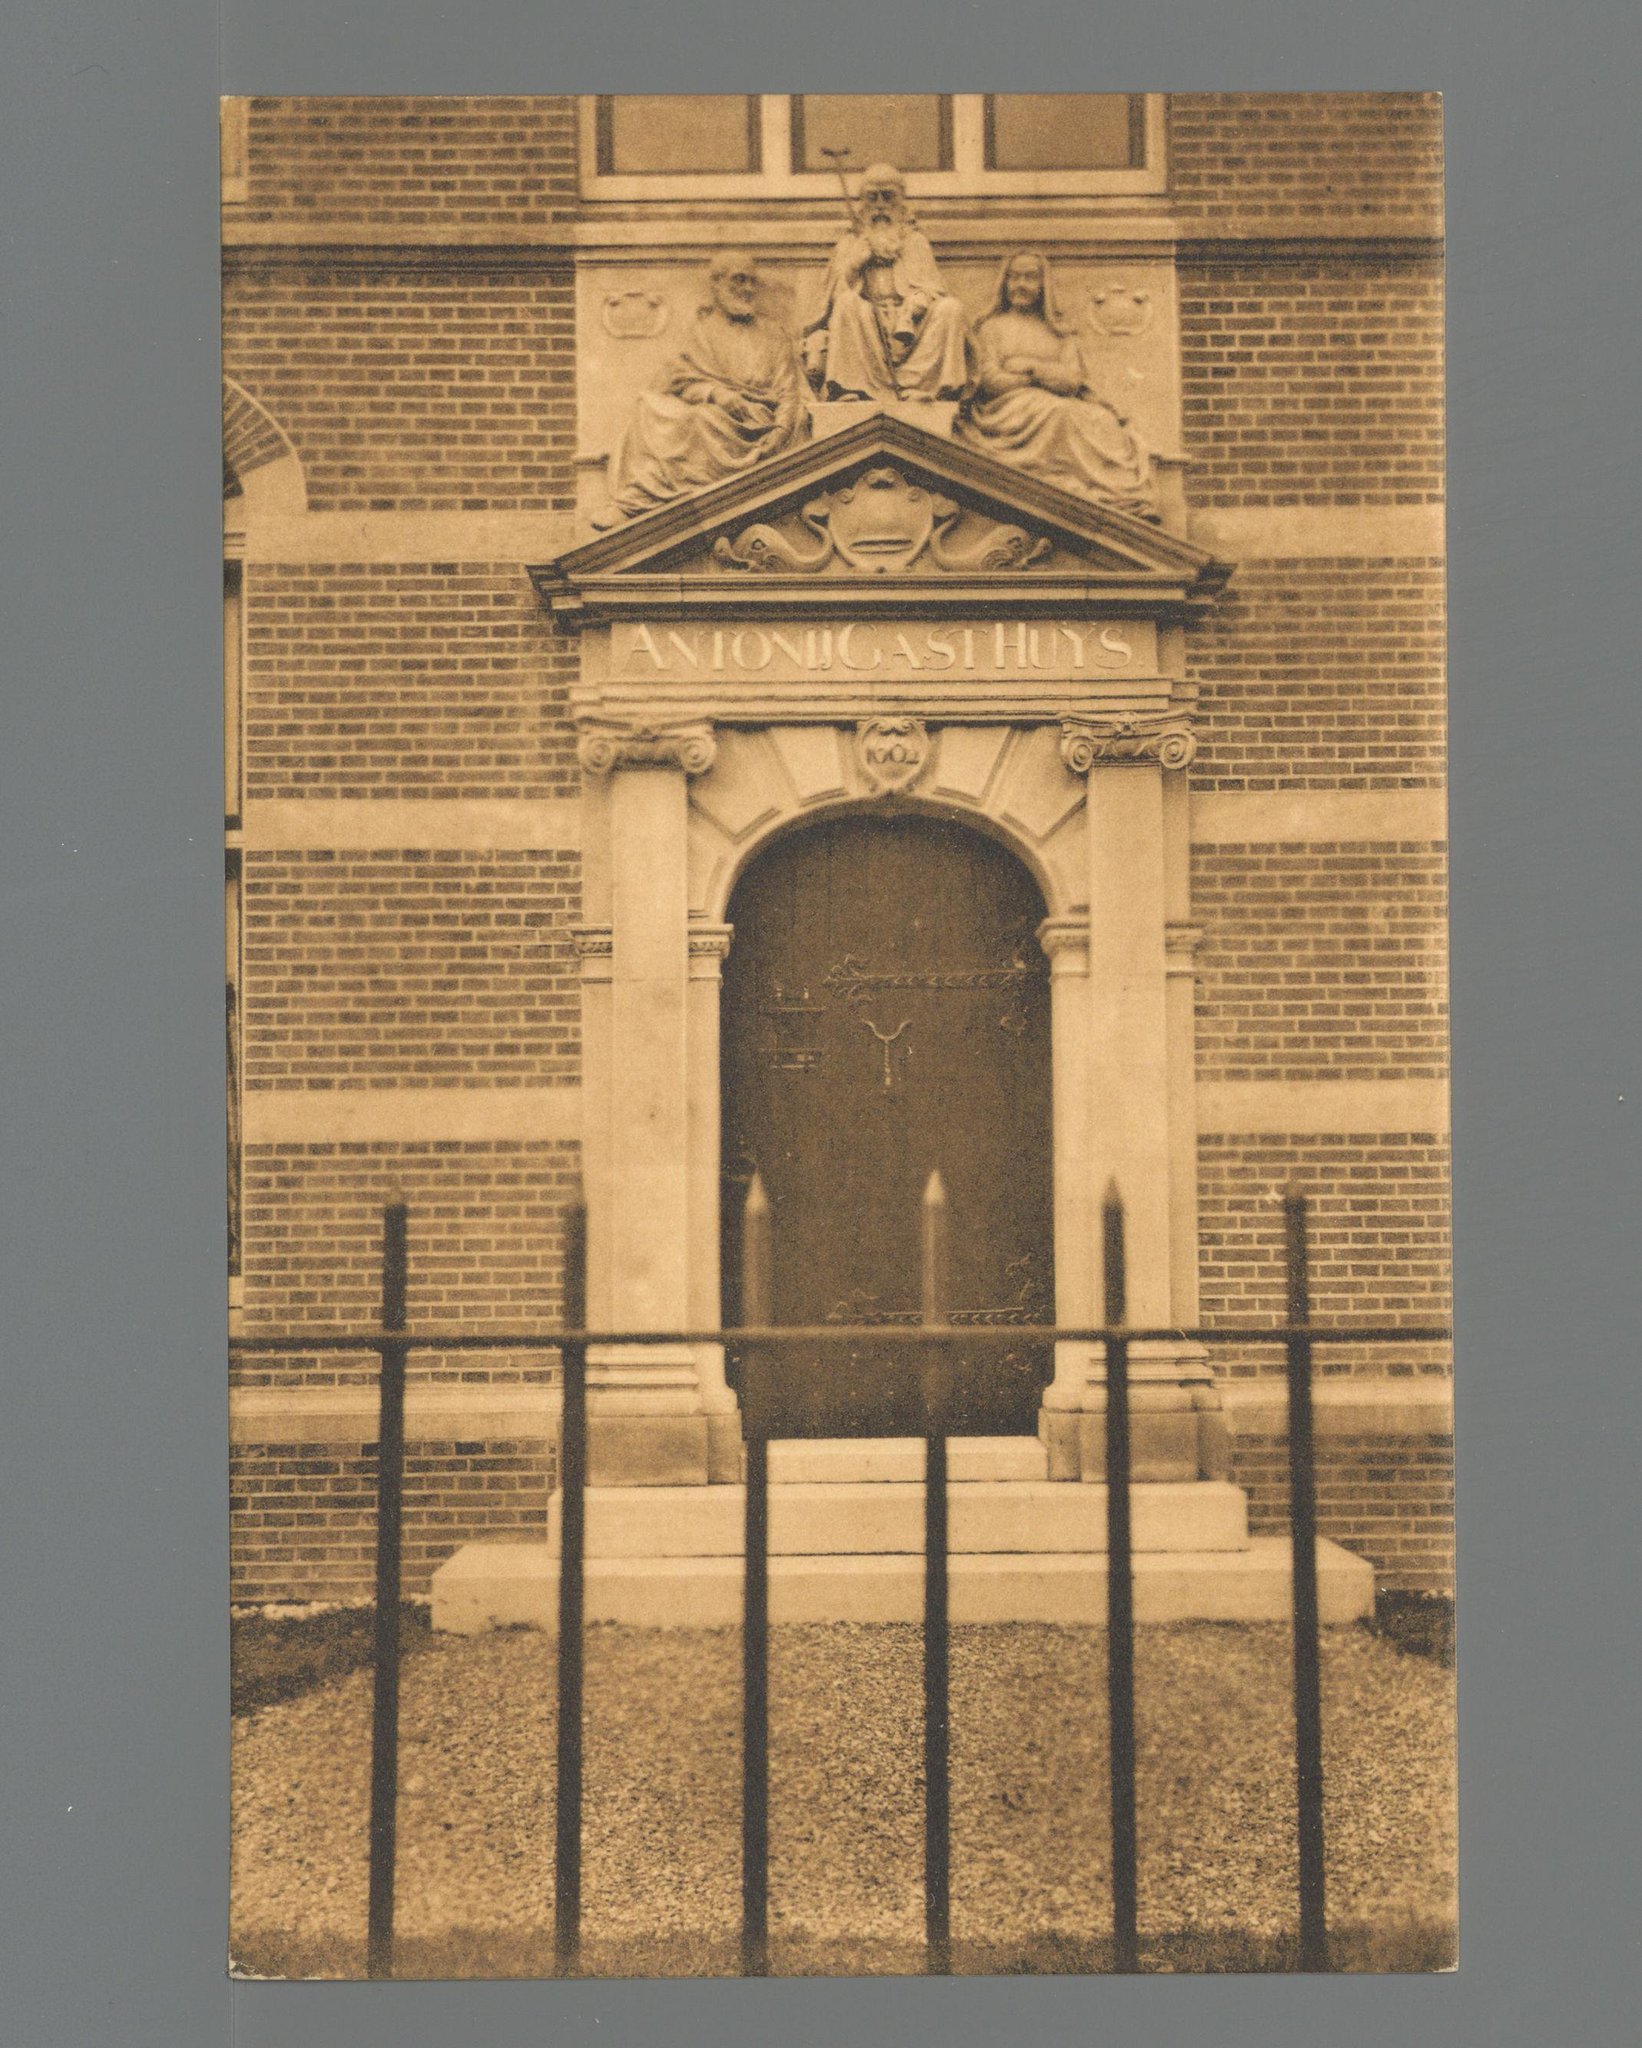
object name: photomechanical print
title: Poortje van het Nieuw Sint Antonie gasthuis - Leeuwarden. (...)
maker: Anonymous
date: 1905-1930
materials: cardboard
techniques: photograph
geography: zwolle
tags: fence, wall, paling, gate, entrance